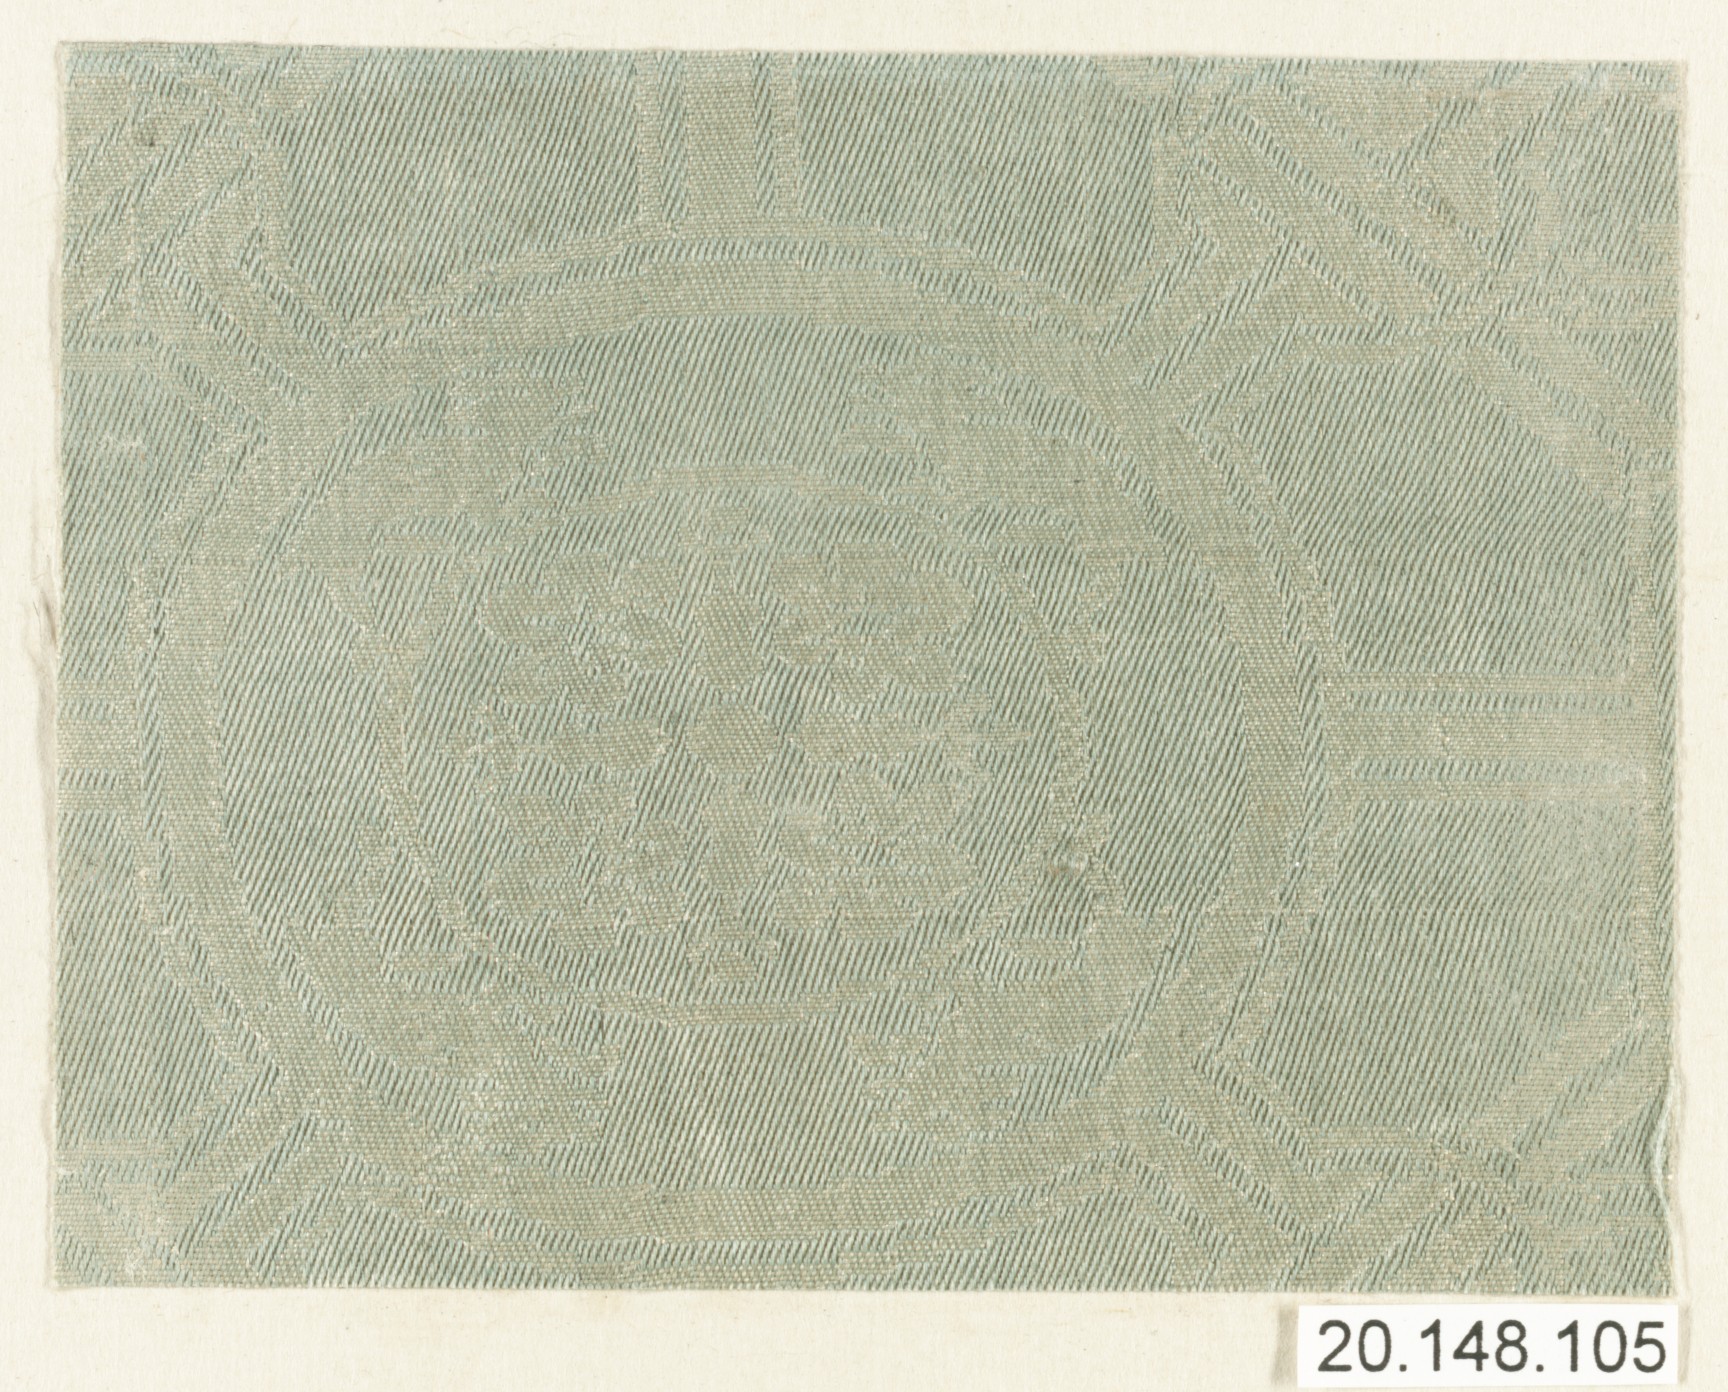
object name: piece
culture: japanese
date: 1601-1700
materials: silk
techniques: compound weave